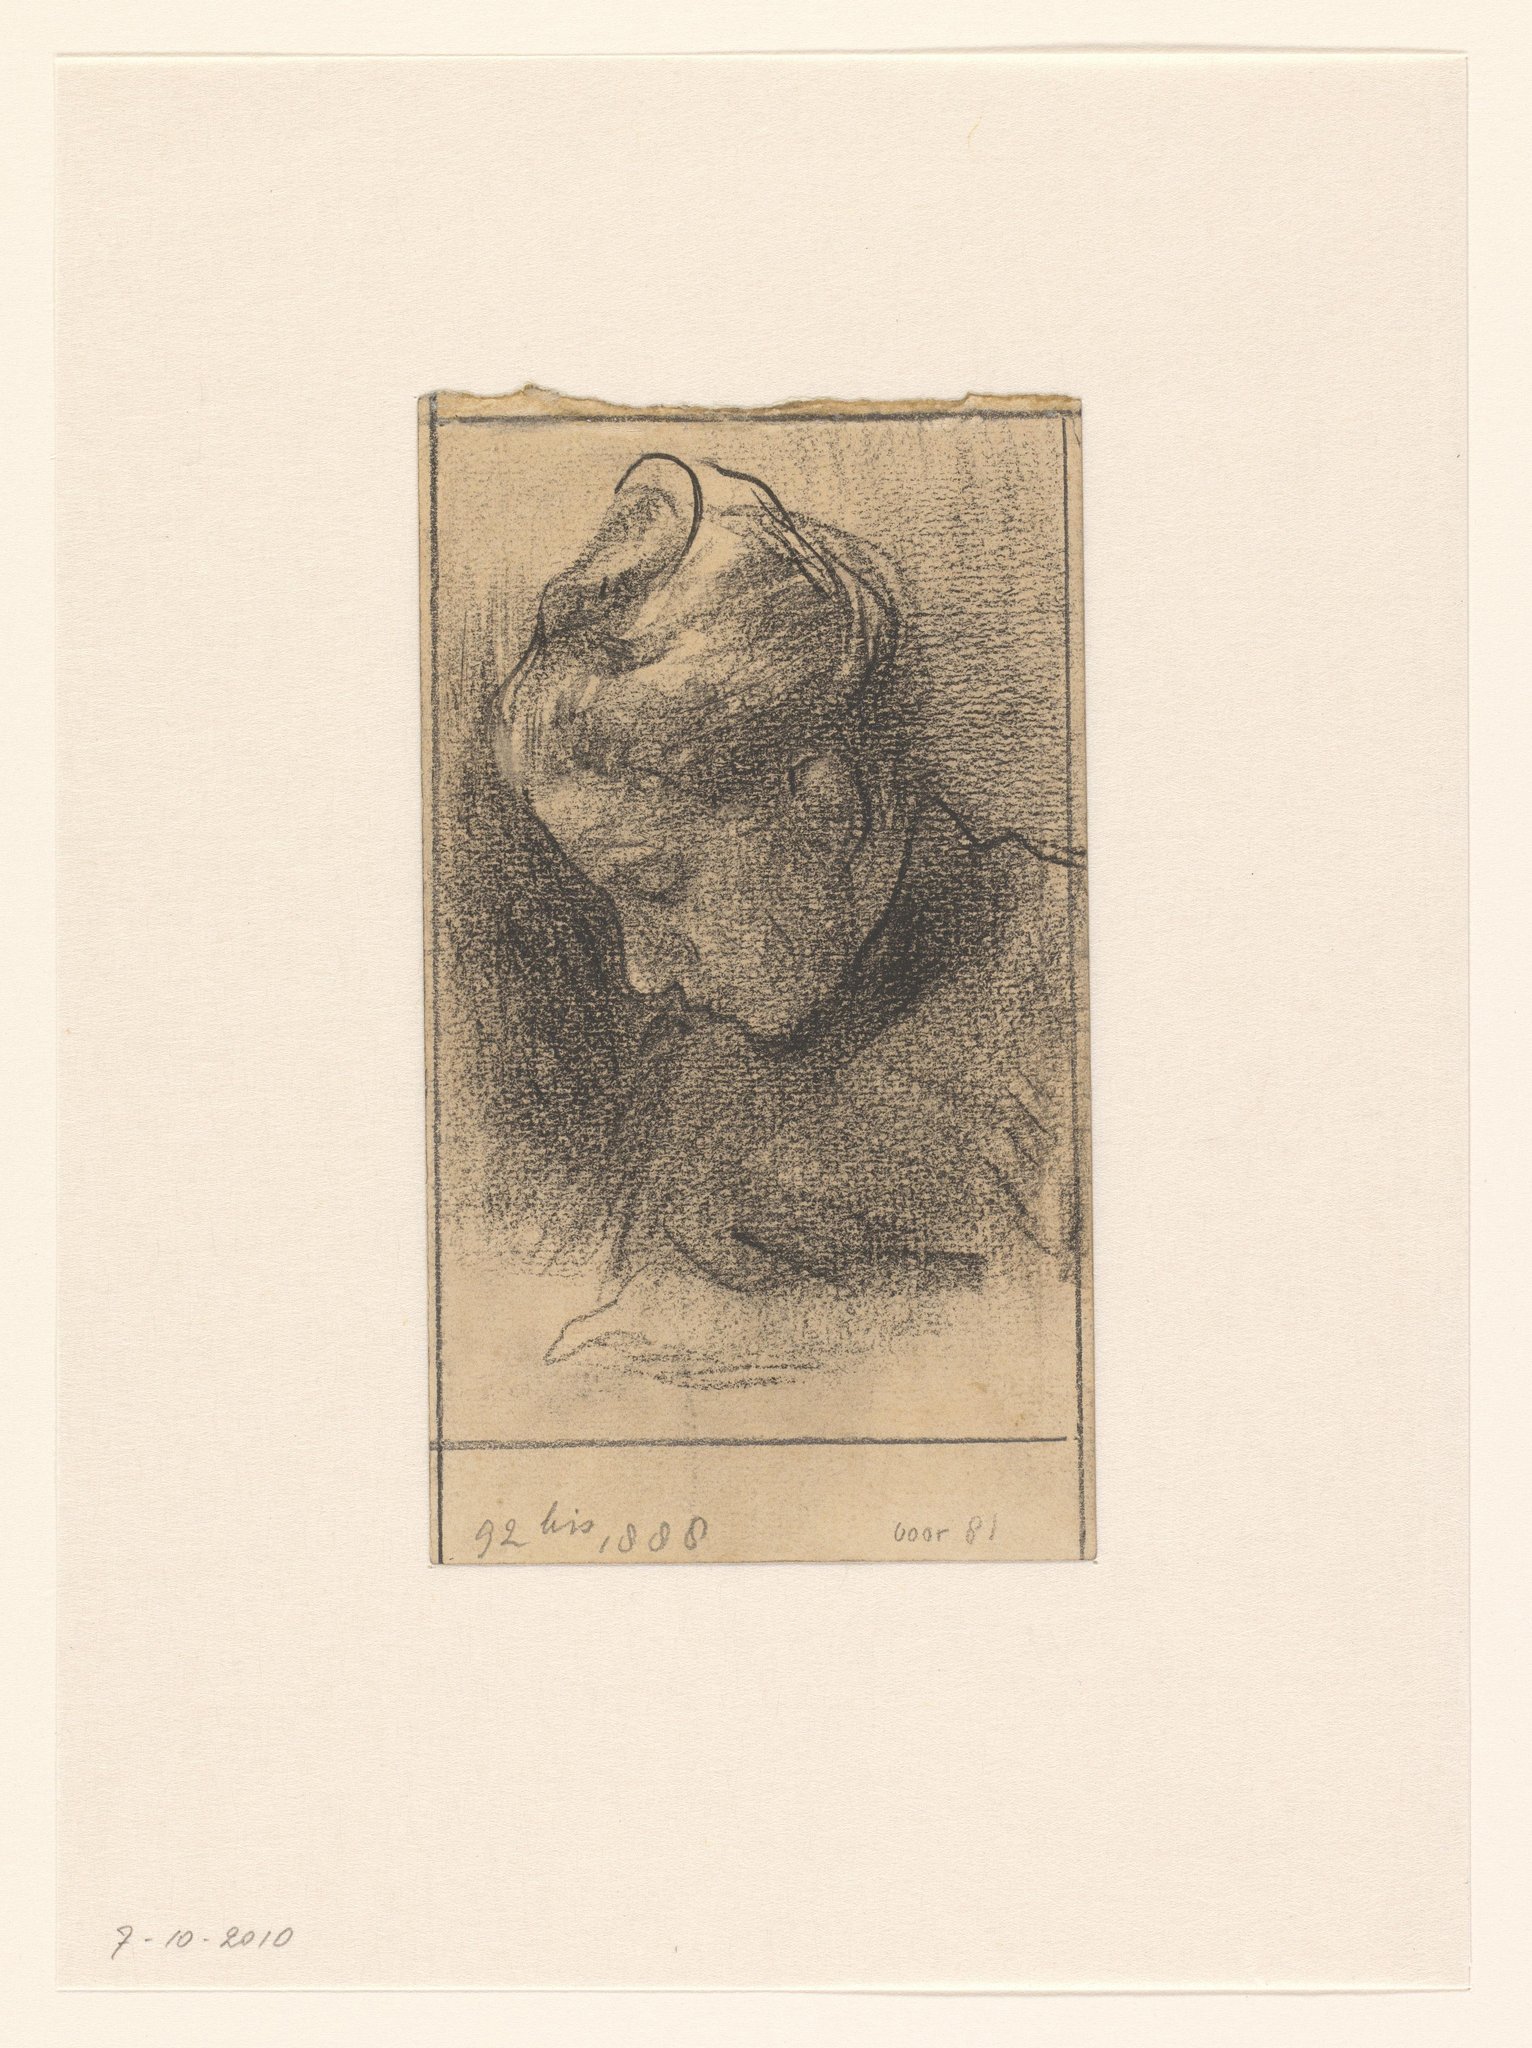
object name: drawing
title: Portret van Justje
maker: jan veth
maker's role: designer, draughtsman, painter, print maker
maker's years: 1864-1925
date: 1888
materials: chalk, paper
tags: historical persons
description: Portret van een vrouw met de naam Justje.